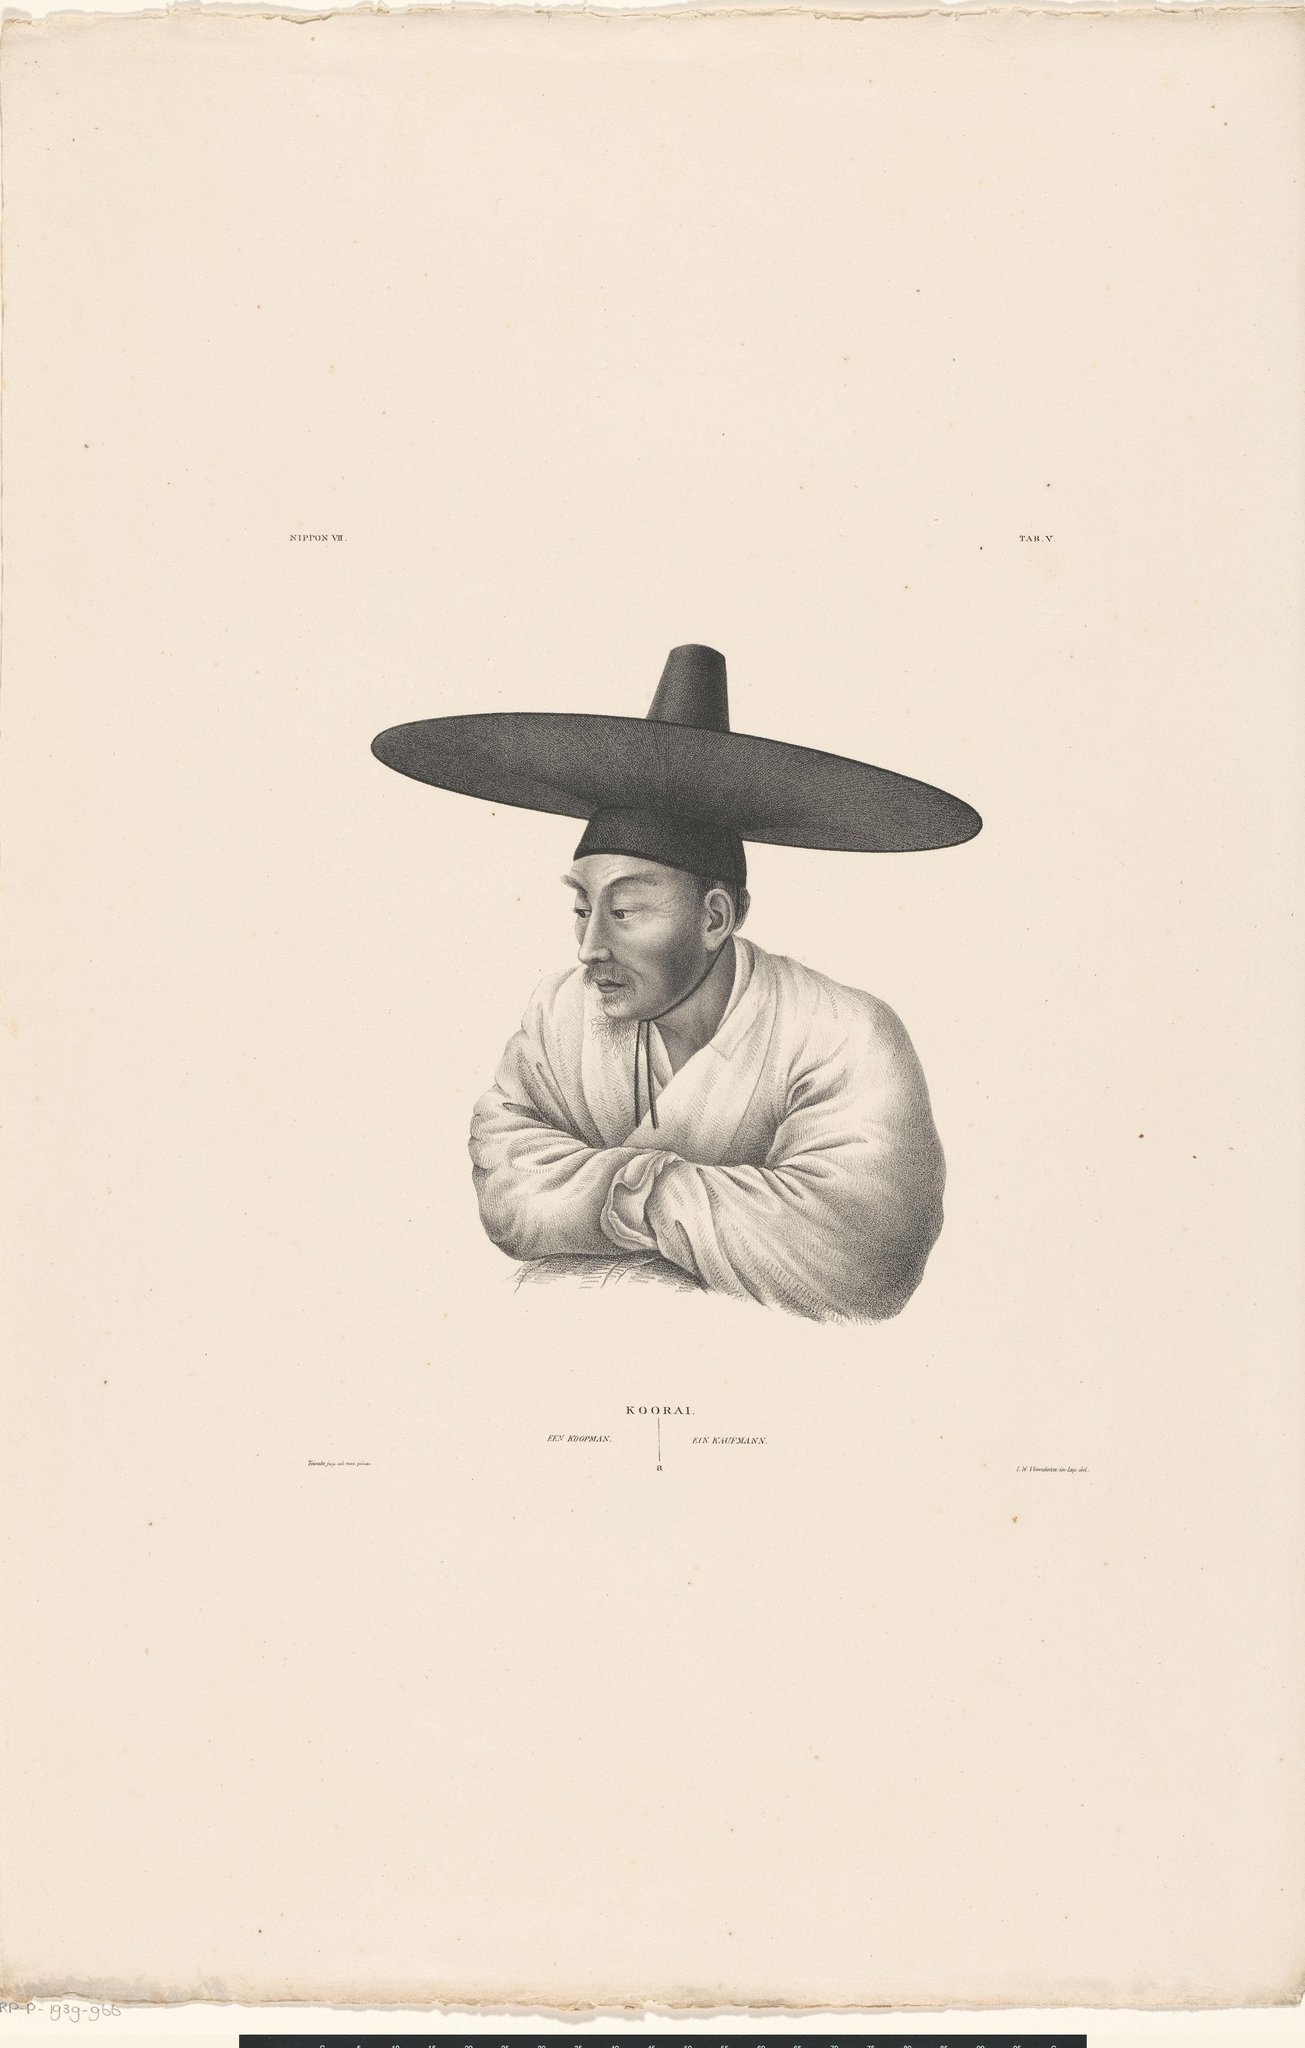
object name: print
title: Koorai / Een koopman / Ein Kaufmann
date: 1810-1872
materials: paper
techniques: lithograph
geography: netherlands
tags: anonymous historical person portrayed, merchant, salesman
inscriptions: collector's mark: Lugt 2760, collector's mark: Lugt 2228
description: Een Koreaans koopman met platte hoed. Aan de bovenzijde vermeld Nippon VII / Tab. V.